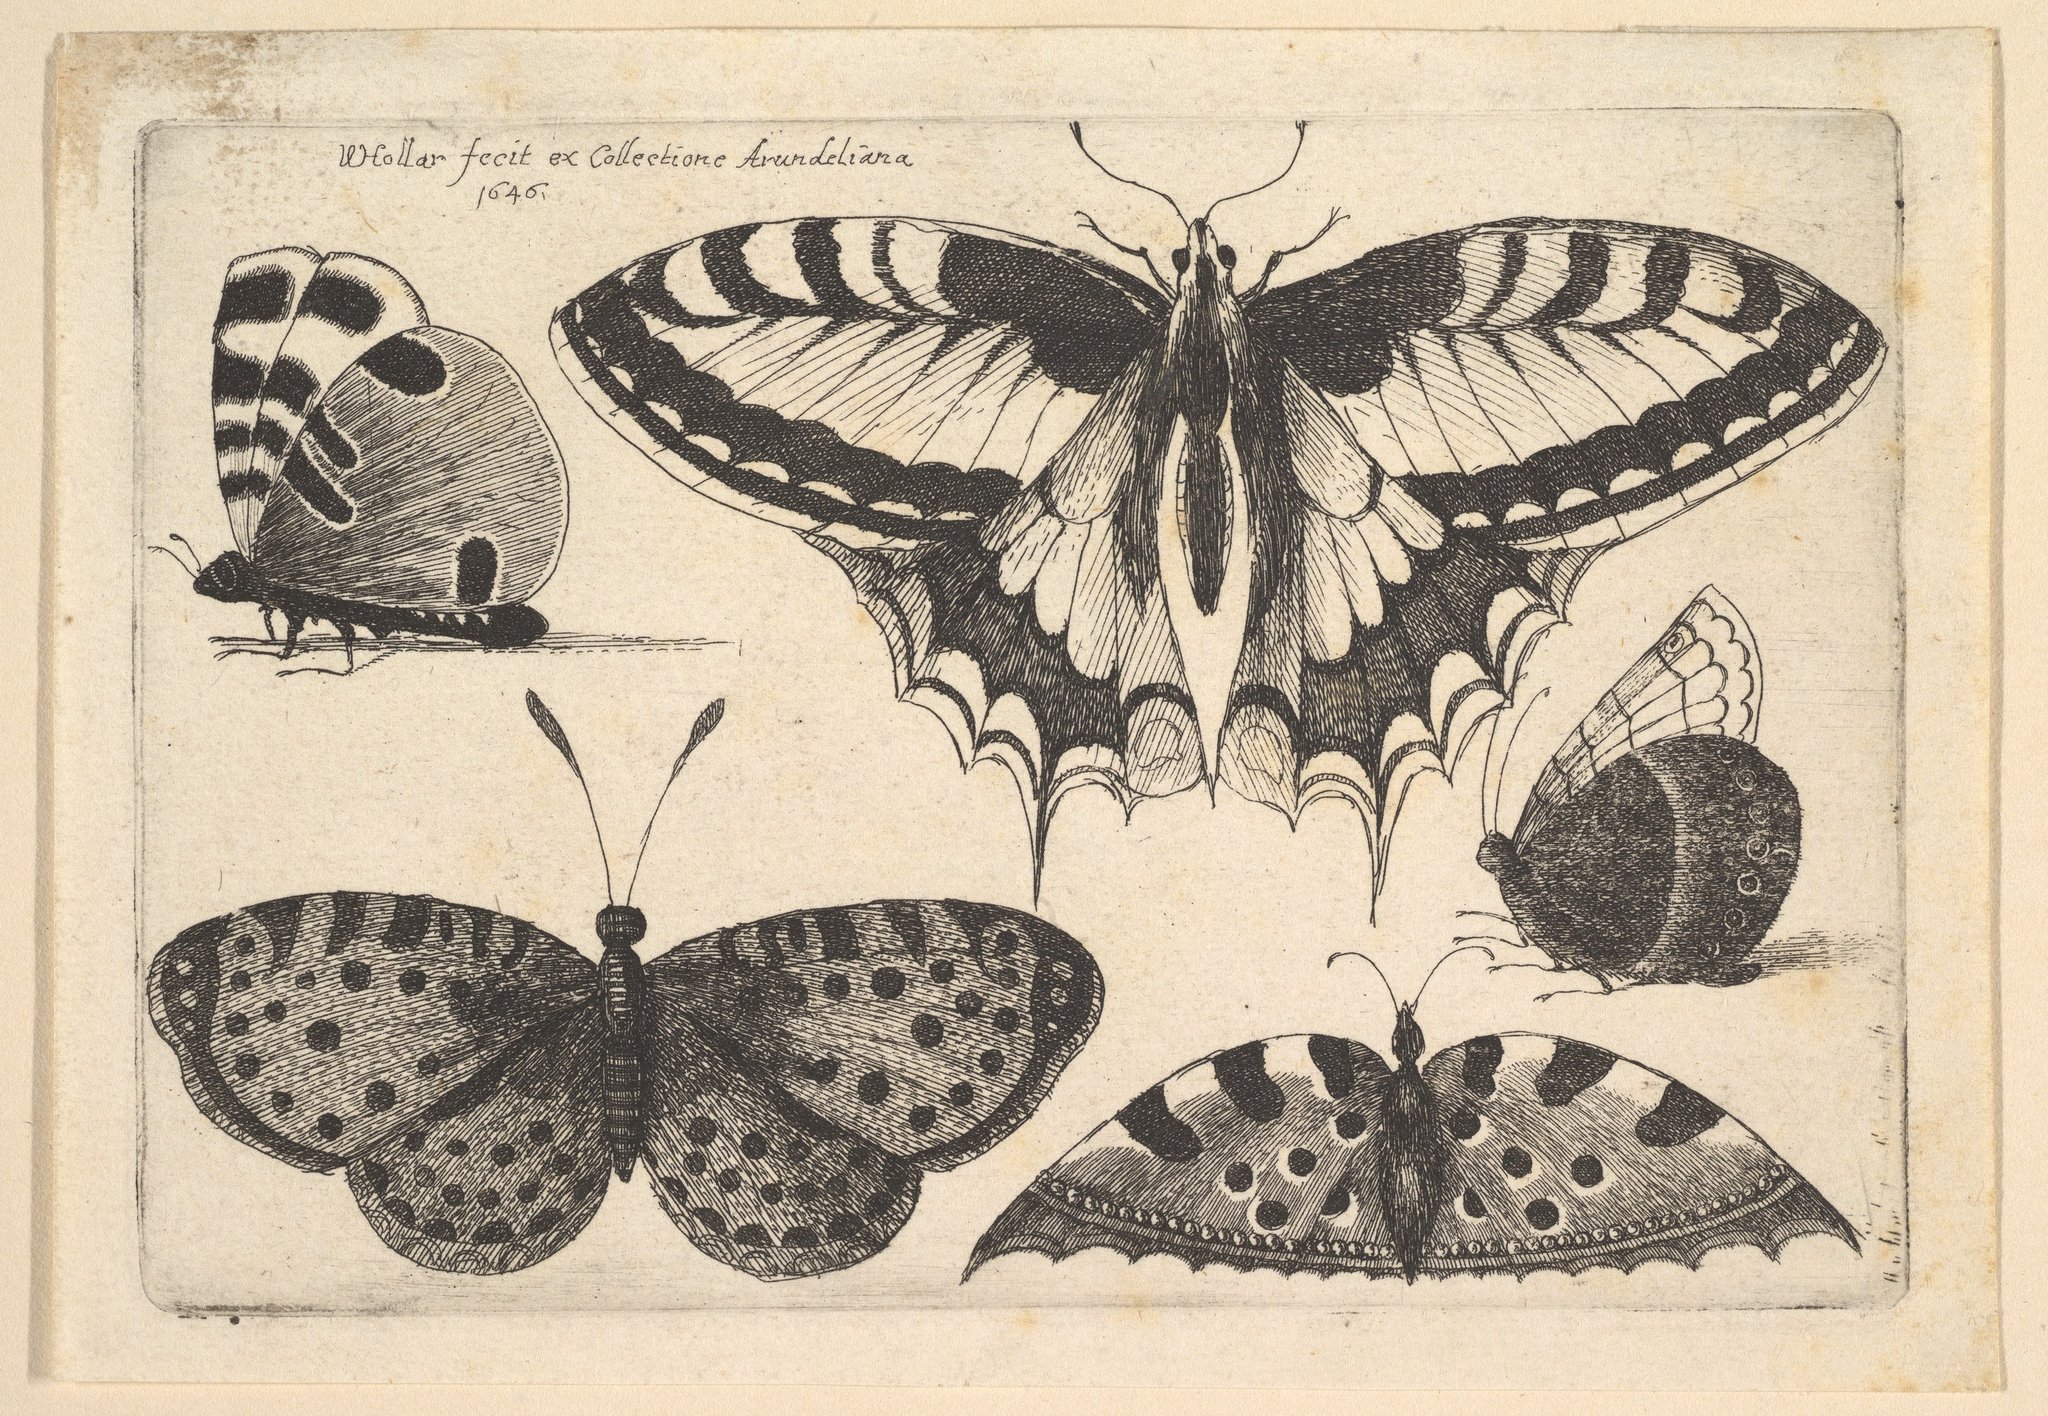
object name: print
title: Five Butterflies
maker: wenceslaus hollar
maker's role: artist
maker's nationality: bohemian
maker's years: 1607-1677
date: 1646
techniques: etching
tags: butterflies